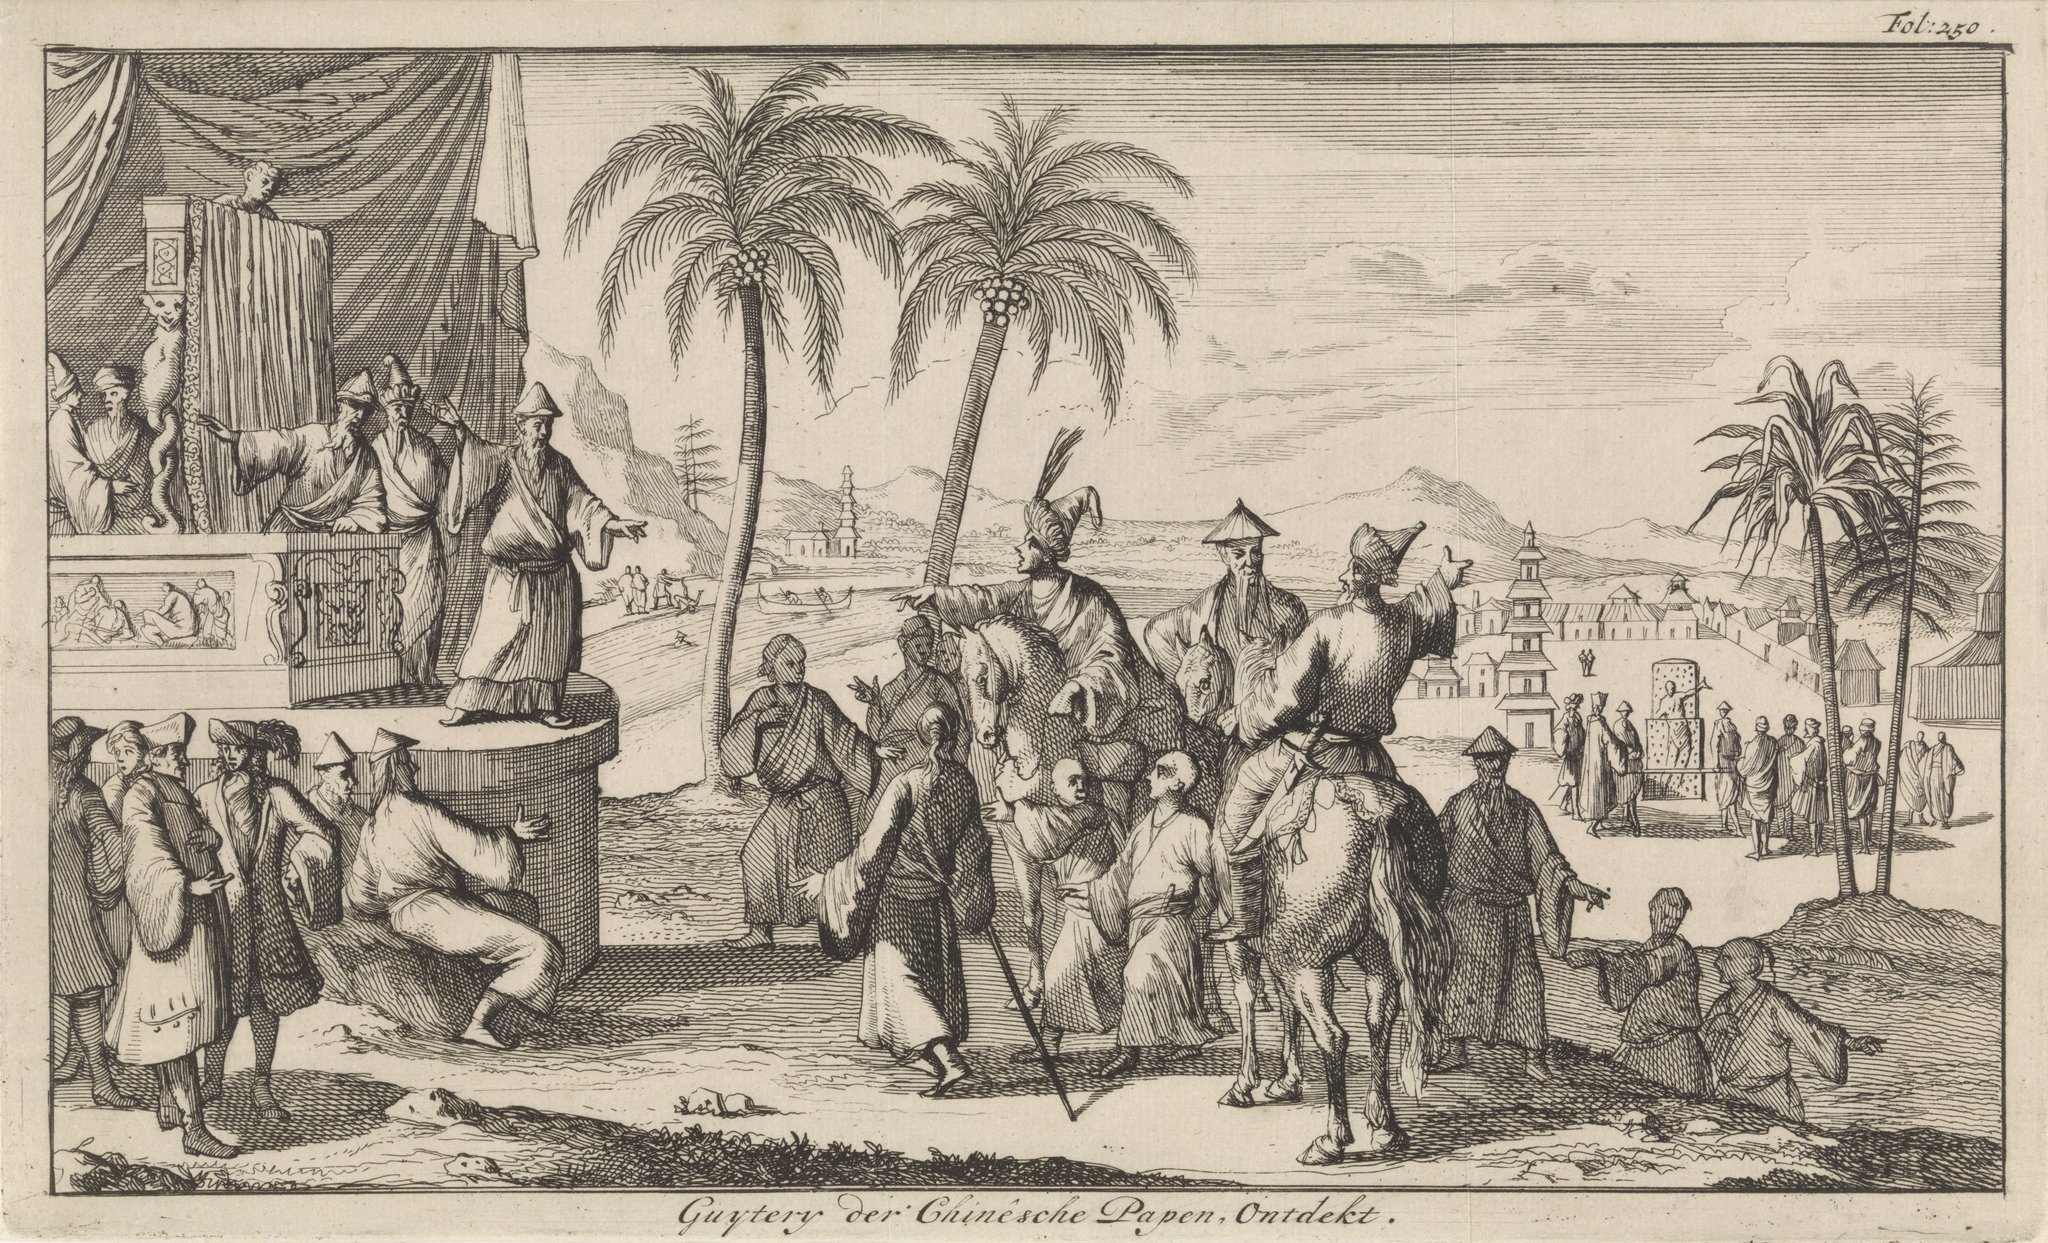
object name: book illustration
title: Europeanen en Chinezen voor een toneel in de openlucht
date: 1698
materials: paper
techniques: etching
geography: the hague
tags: europeans, set, scenery ~ stage, chinese, landscapes in the non-temperate zone, exotic landscapes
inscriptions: collector's mark: Lugt 2228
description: Illustratie uit: Le Comte, Louis. Beschryvinge van het machtige keyserryk China, 2 delen. Den Haag: Engelbrecht Boucquet, 1698.